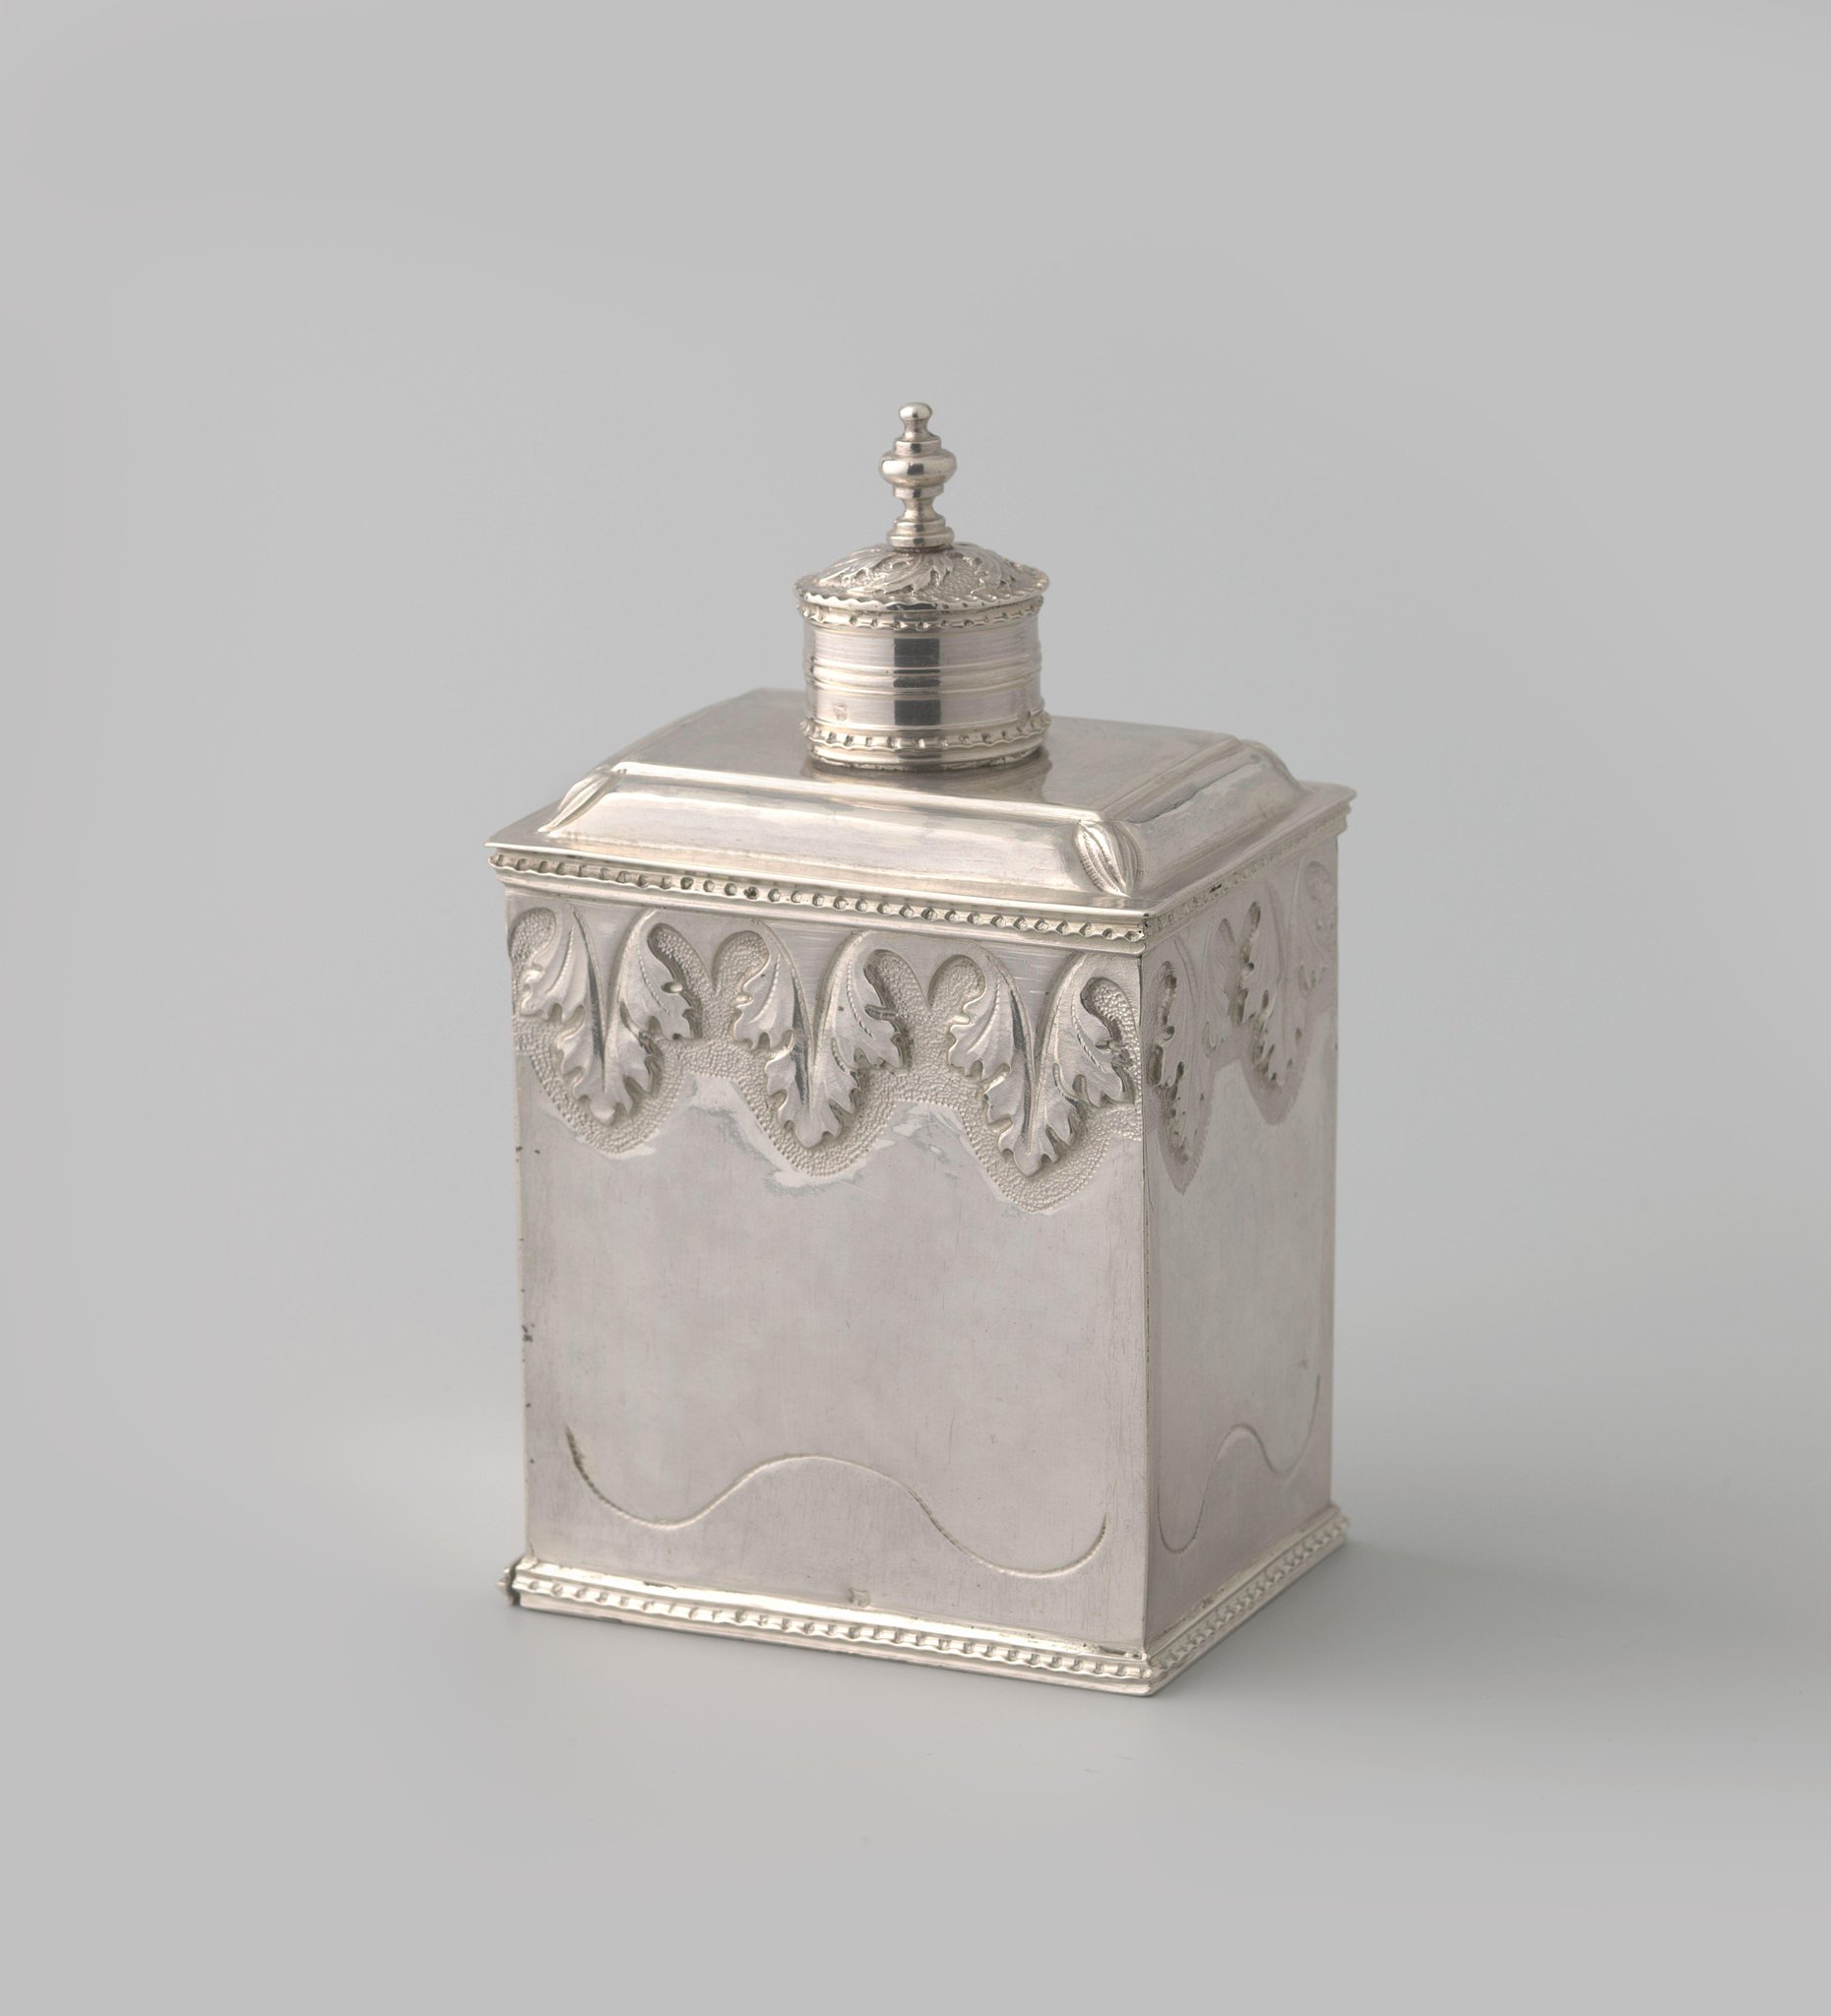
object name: tea caddy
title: Theebus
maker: Anonymous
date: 1722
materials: silver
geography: utrecht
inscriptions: mark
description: Tea caddy. Silver. Utrecht, 1722, maker's mark unknown.